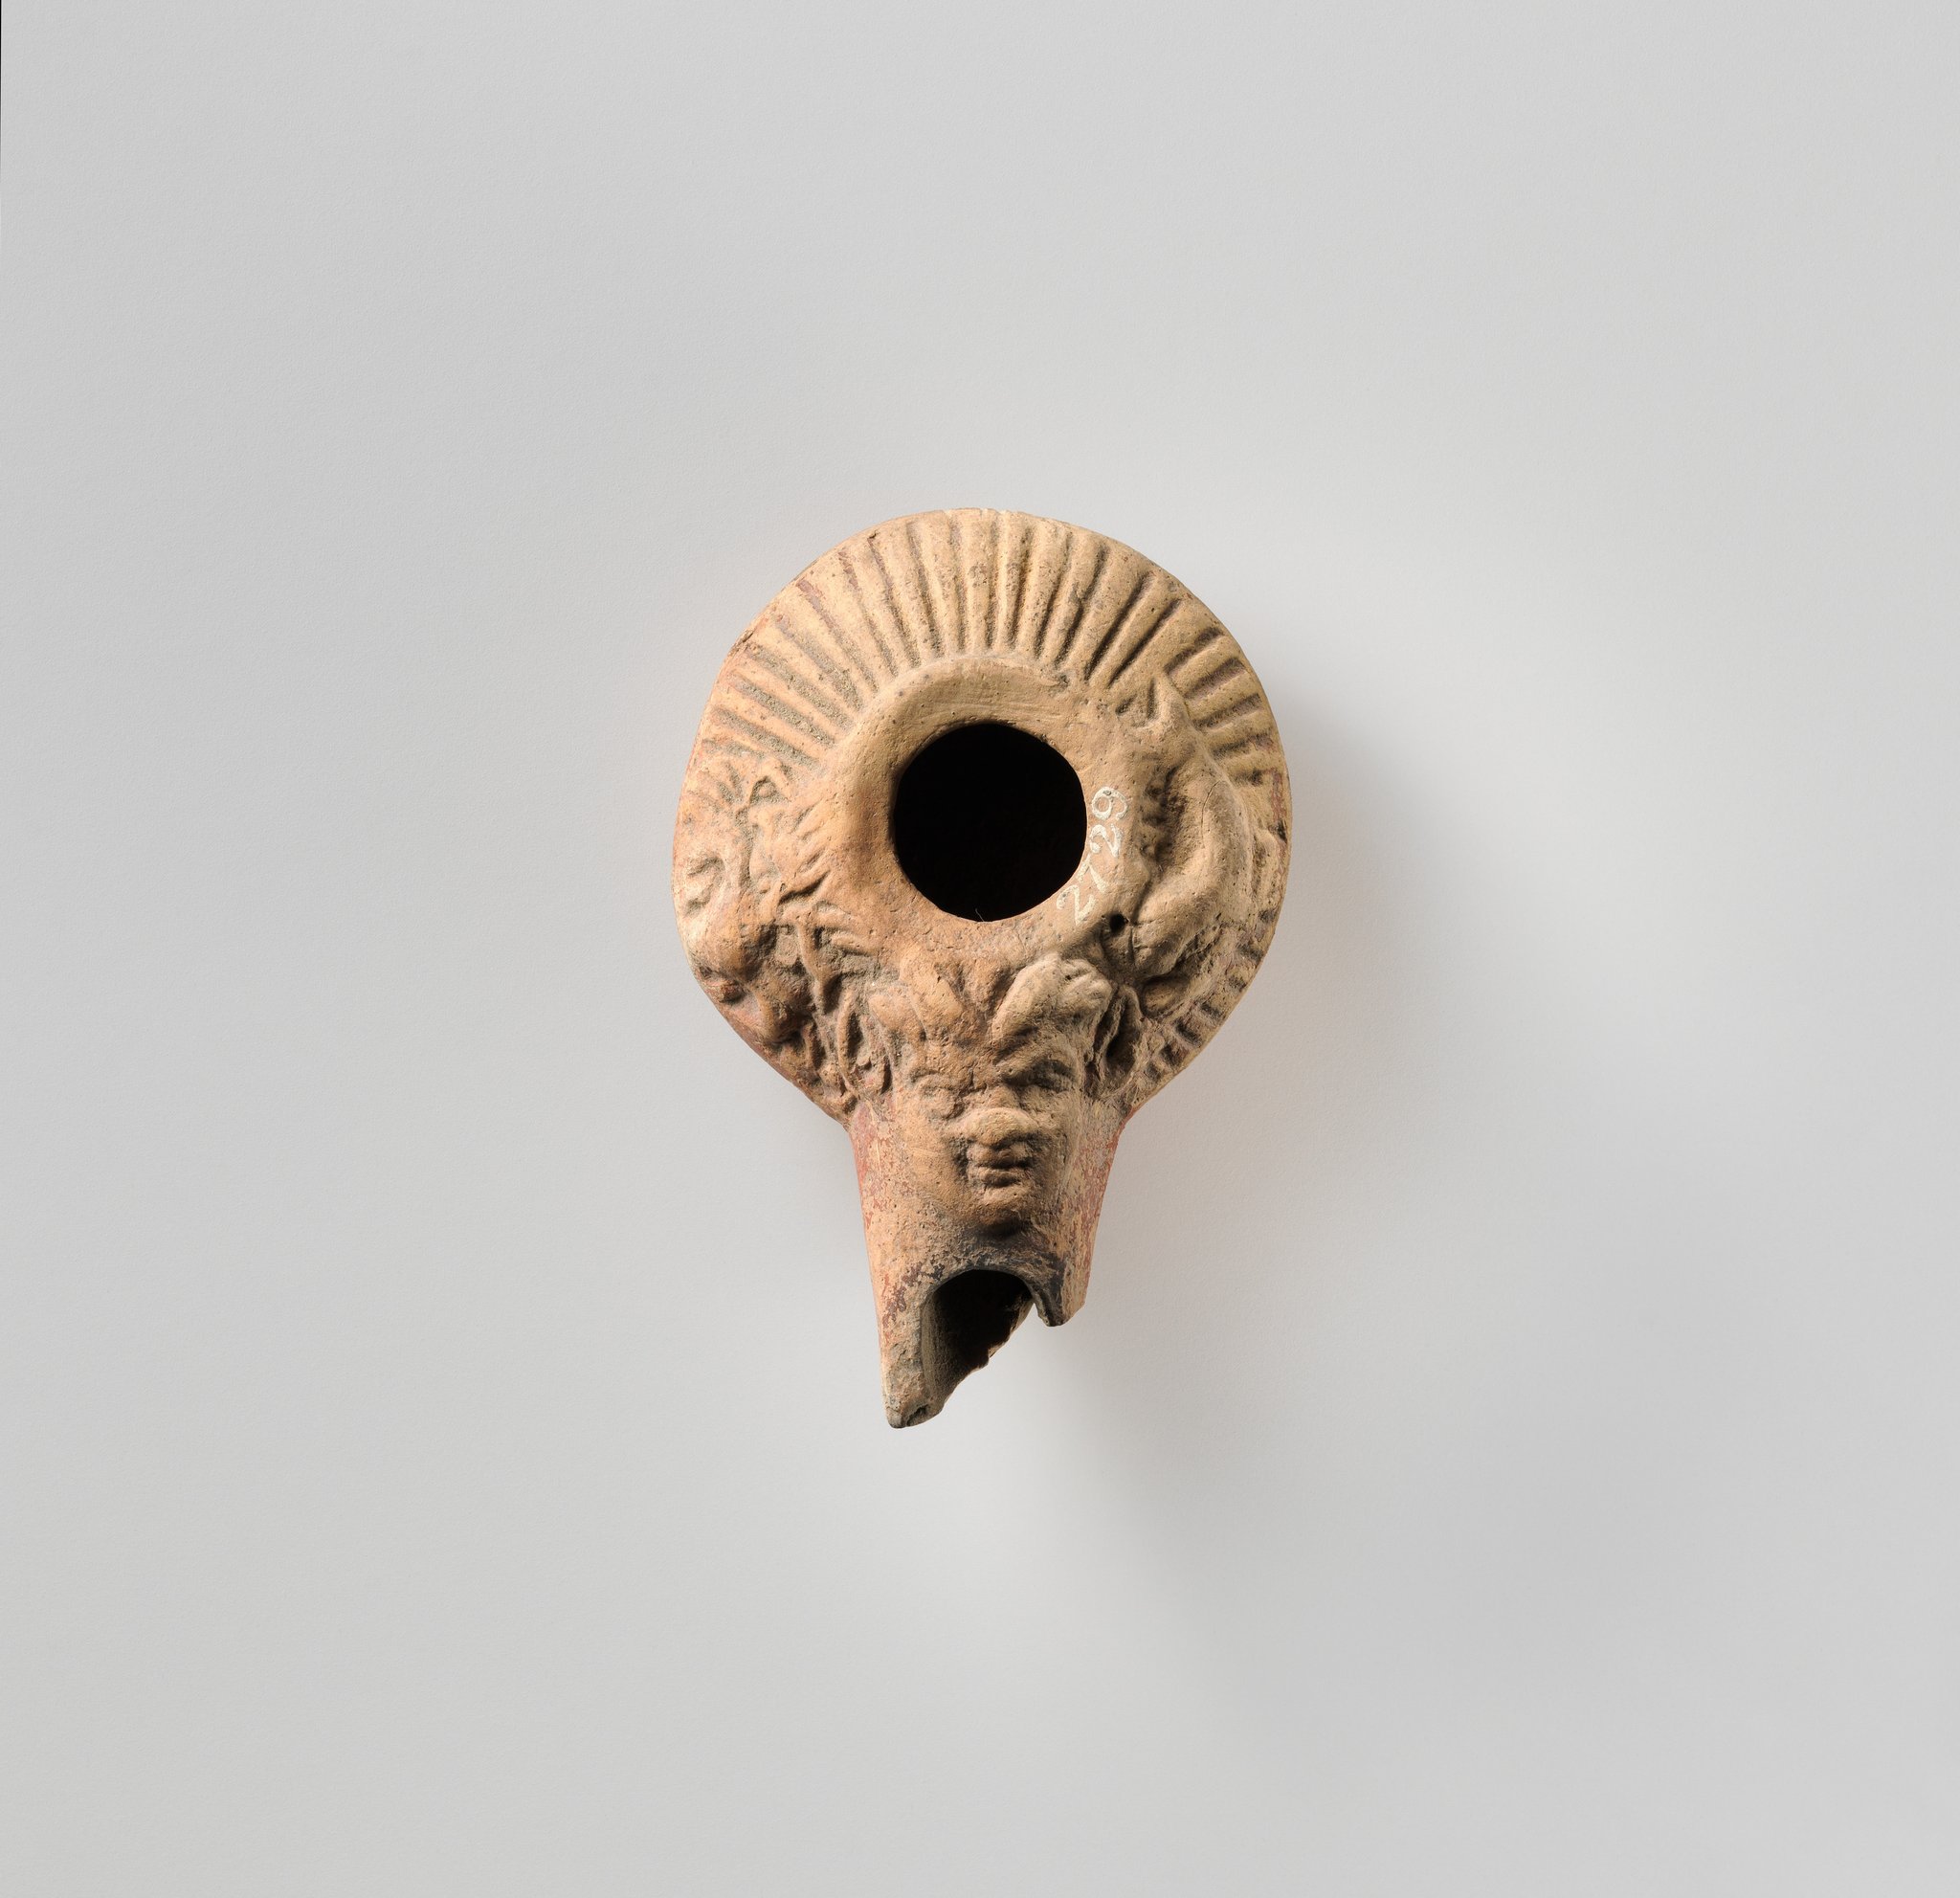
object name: lamp, convex top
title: Terracotta oil lamp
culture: greek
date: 7000 BCE-330 CE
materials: terracotta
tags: satyrs